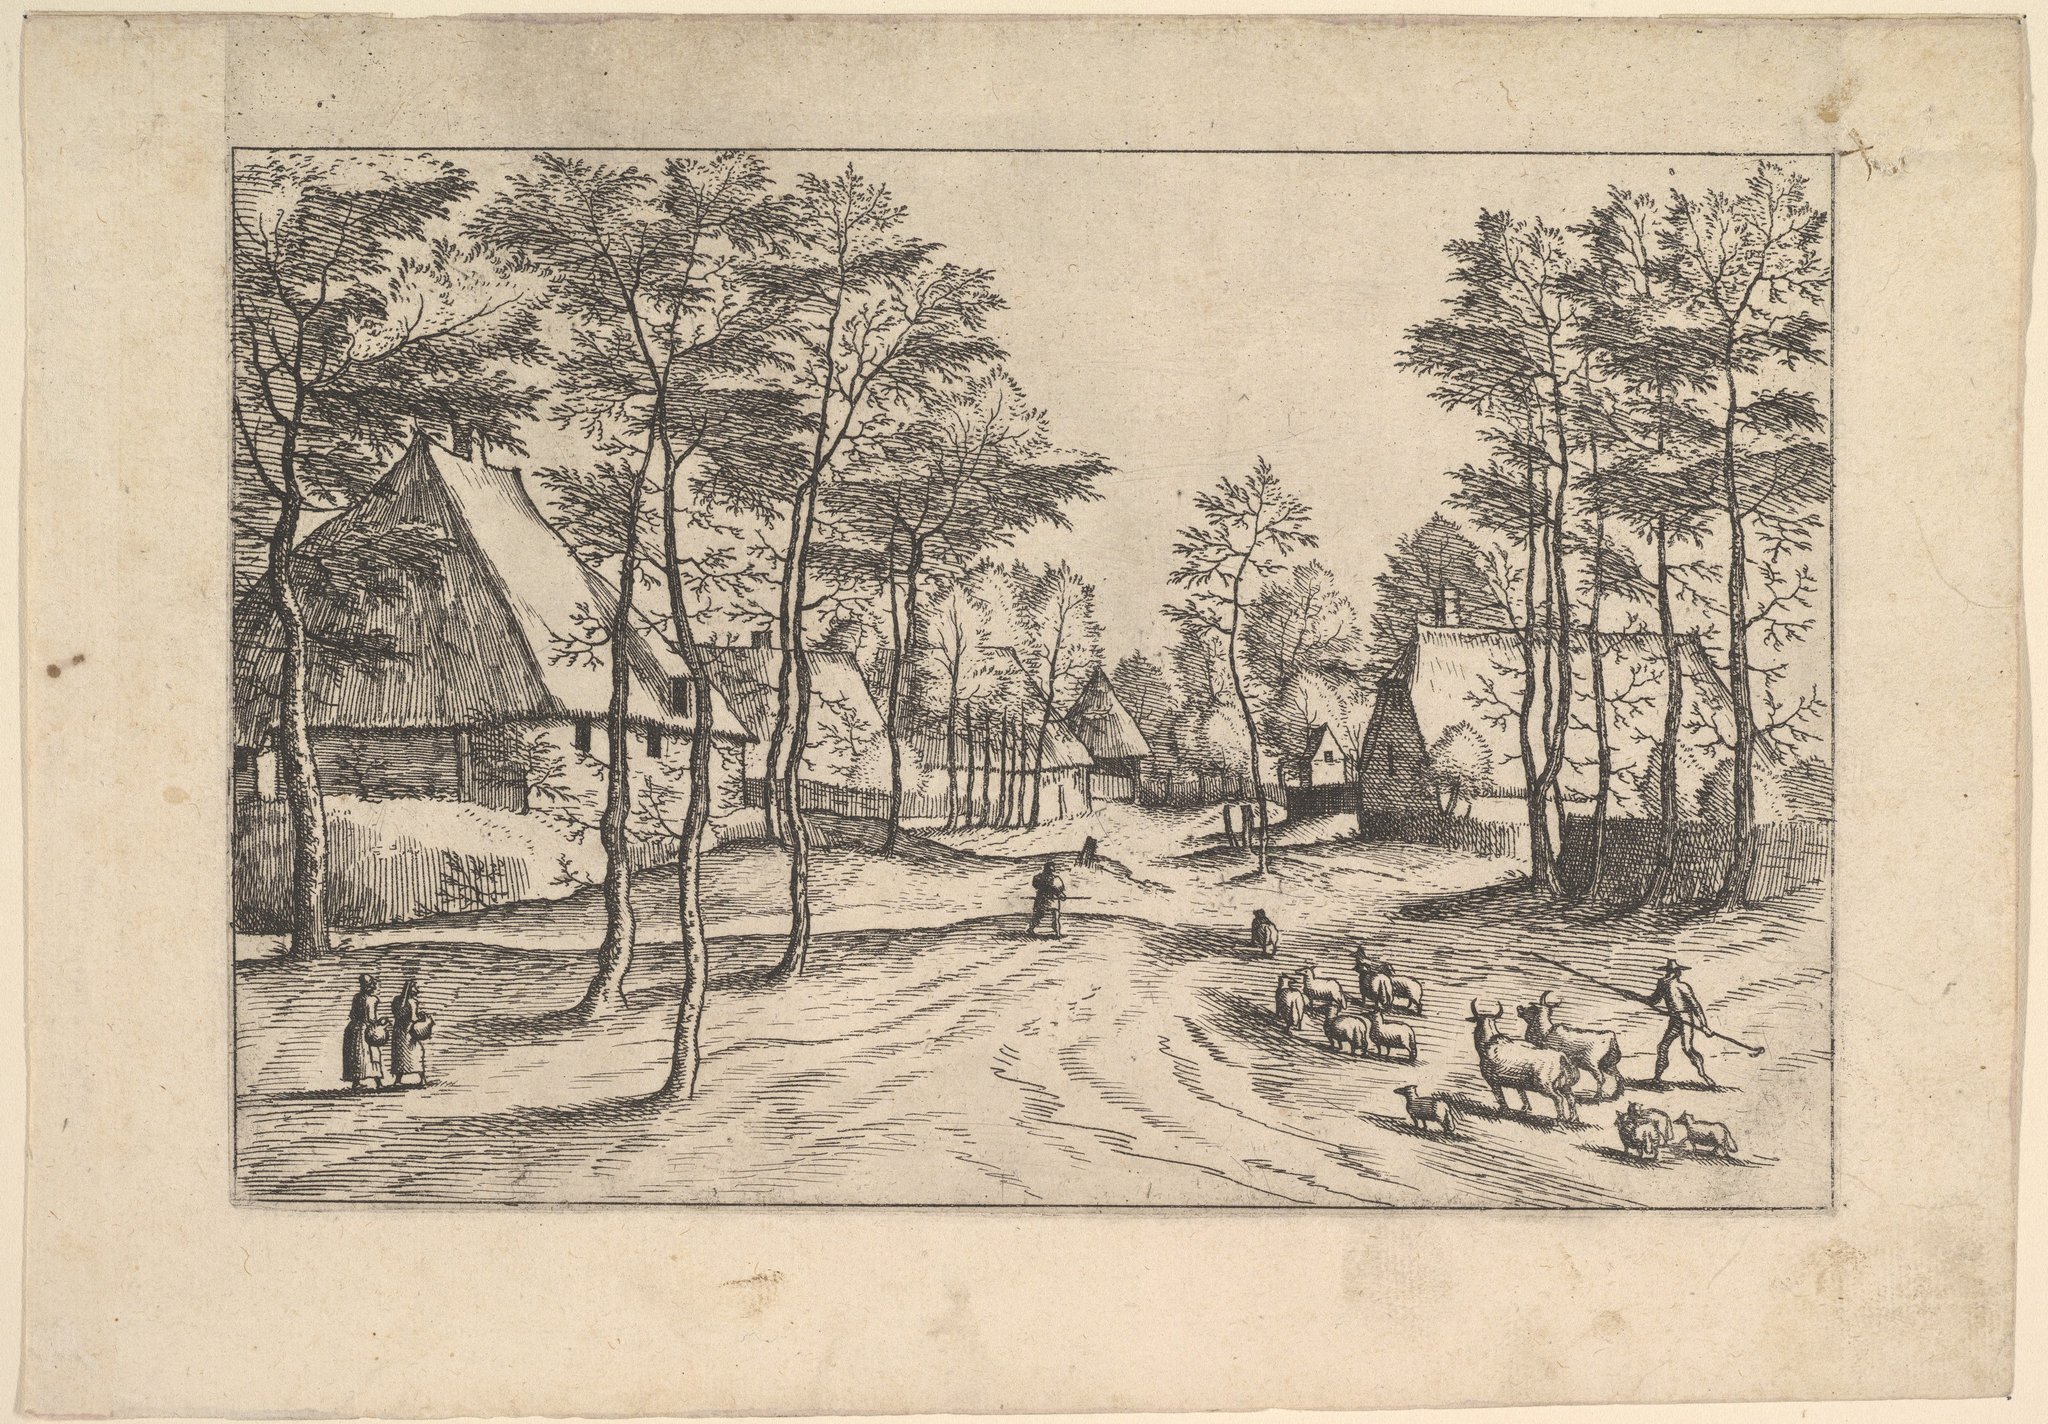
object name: print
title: Village Street, cattle, sheep and herdsman in the foreground from Praediorum villarum et rusticarum casularum icones elenoantissimae ad vivum in apre deformatae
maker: johannes van doetecum i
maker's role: artist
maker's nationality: netherlandish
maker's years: 1528-1605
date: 1559-1561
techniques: etching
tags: animals,houses,streets,villages,trees